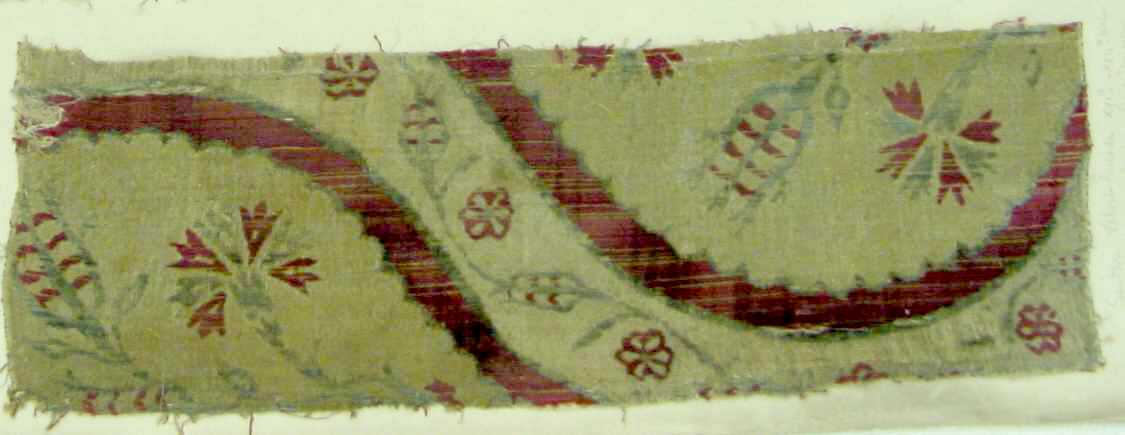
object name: textile fragment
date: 1501-1700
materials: metal thread, silk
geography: turkey